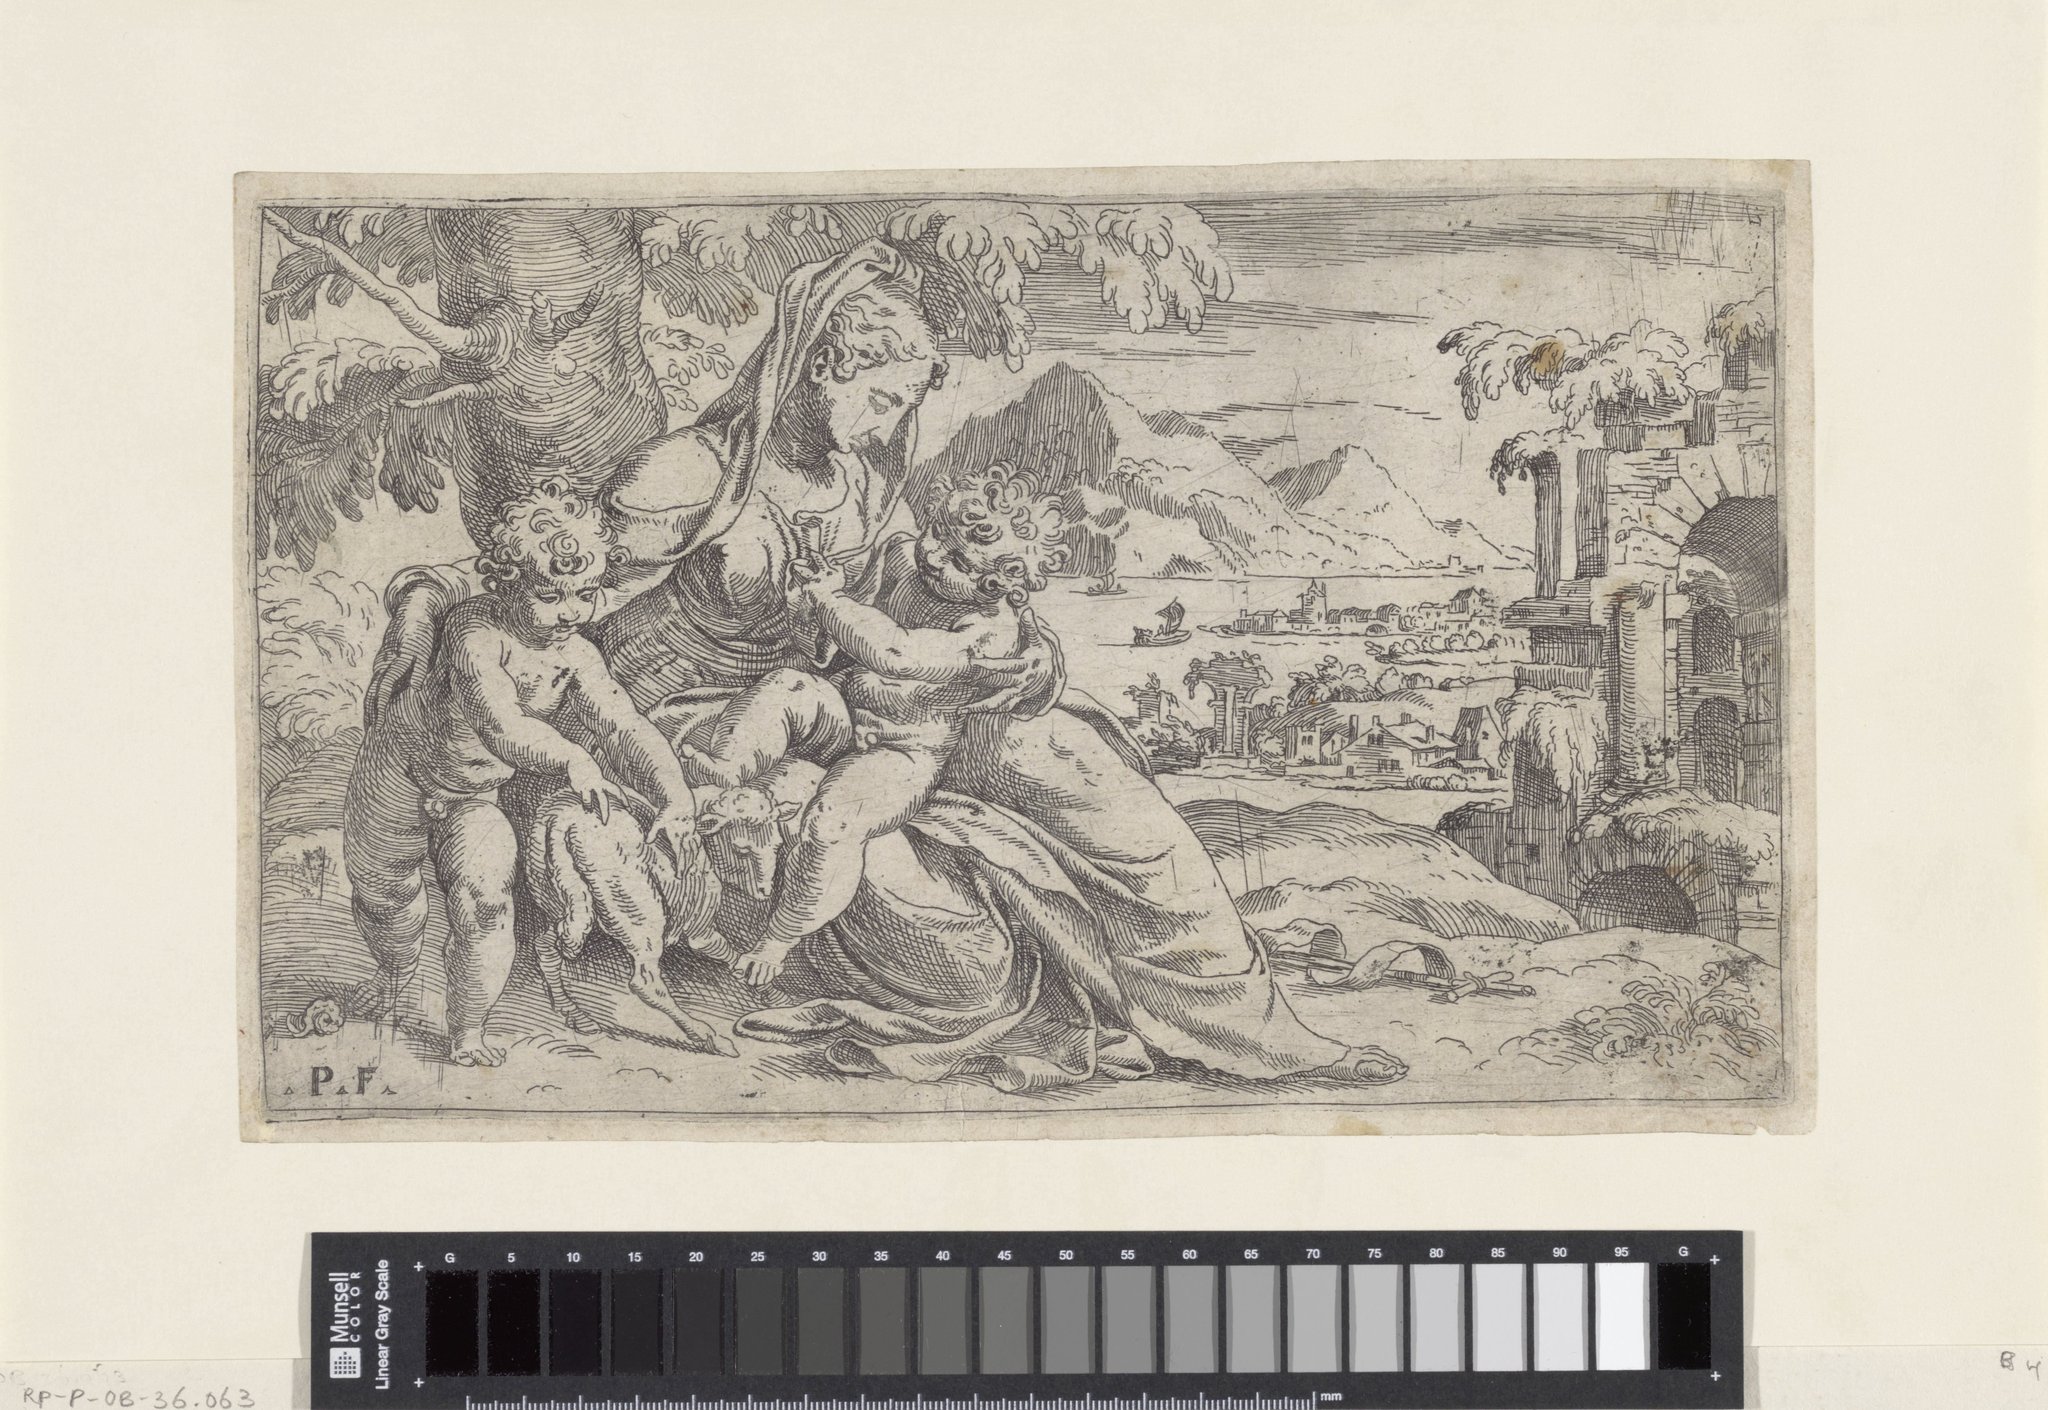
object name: print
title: Liefde (Caritas)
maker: paolo farinati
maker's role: painter, print maker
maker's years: 1524-1606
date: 1534-1606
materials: paper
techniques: etching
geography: italy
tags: charity, 'caritas'; 'carità' (ripa) ~ one of the three theological virtues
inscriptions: collector's mark: Lugt 240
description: Een vrouw (Caritas) met twee kleine kinderen in een landschap.